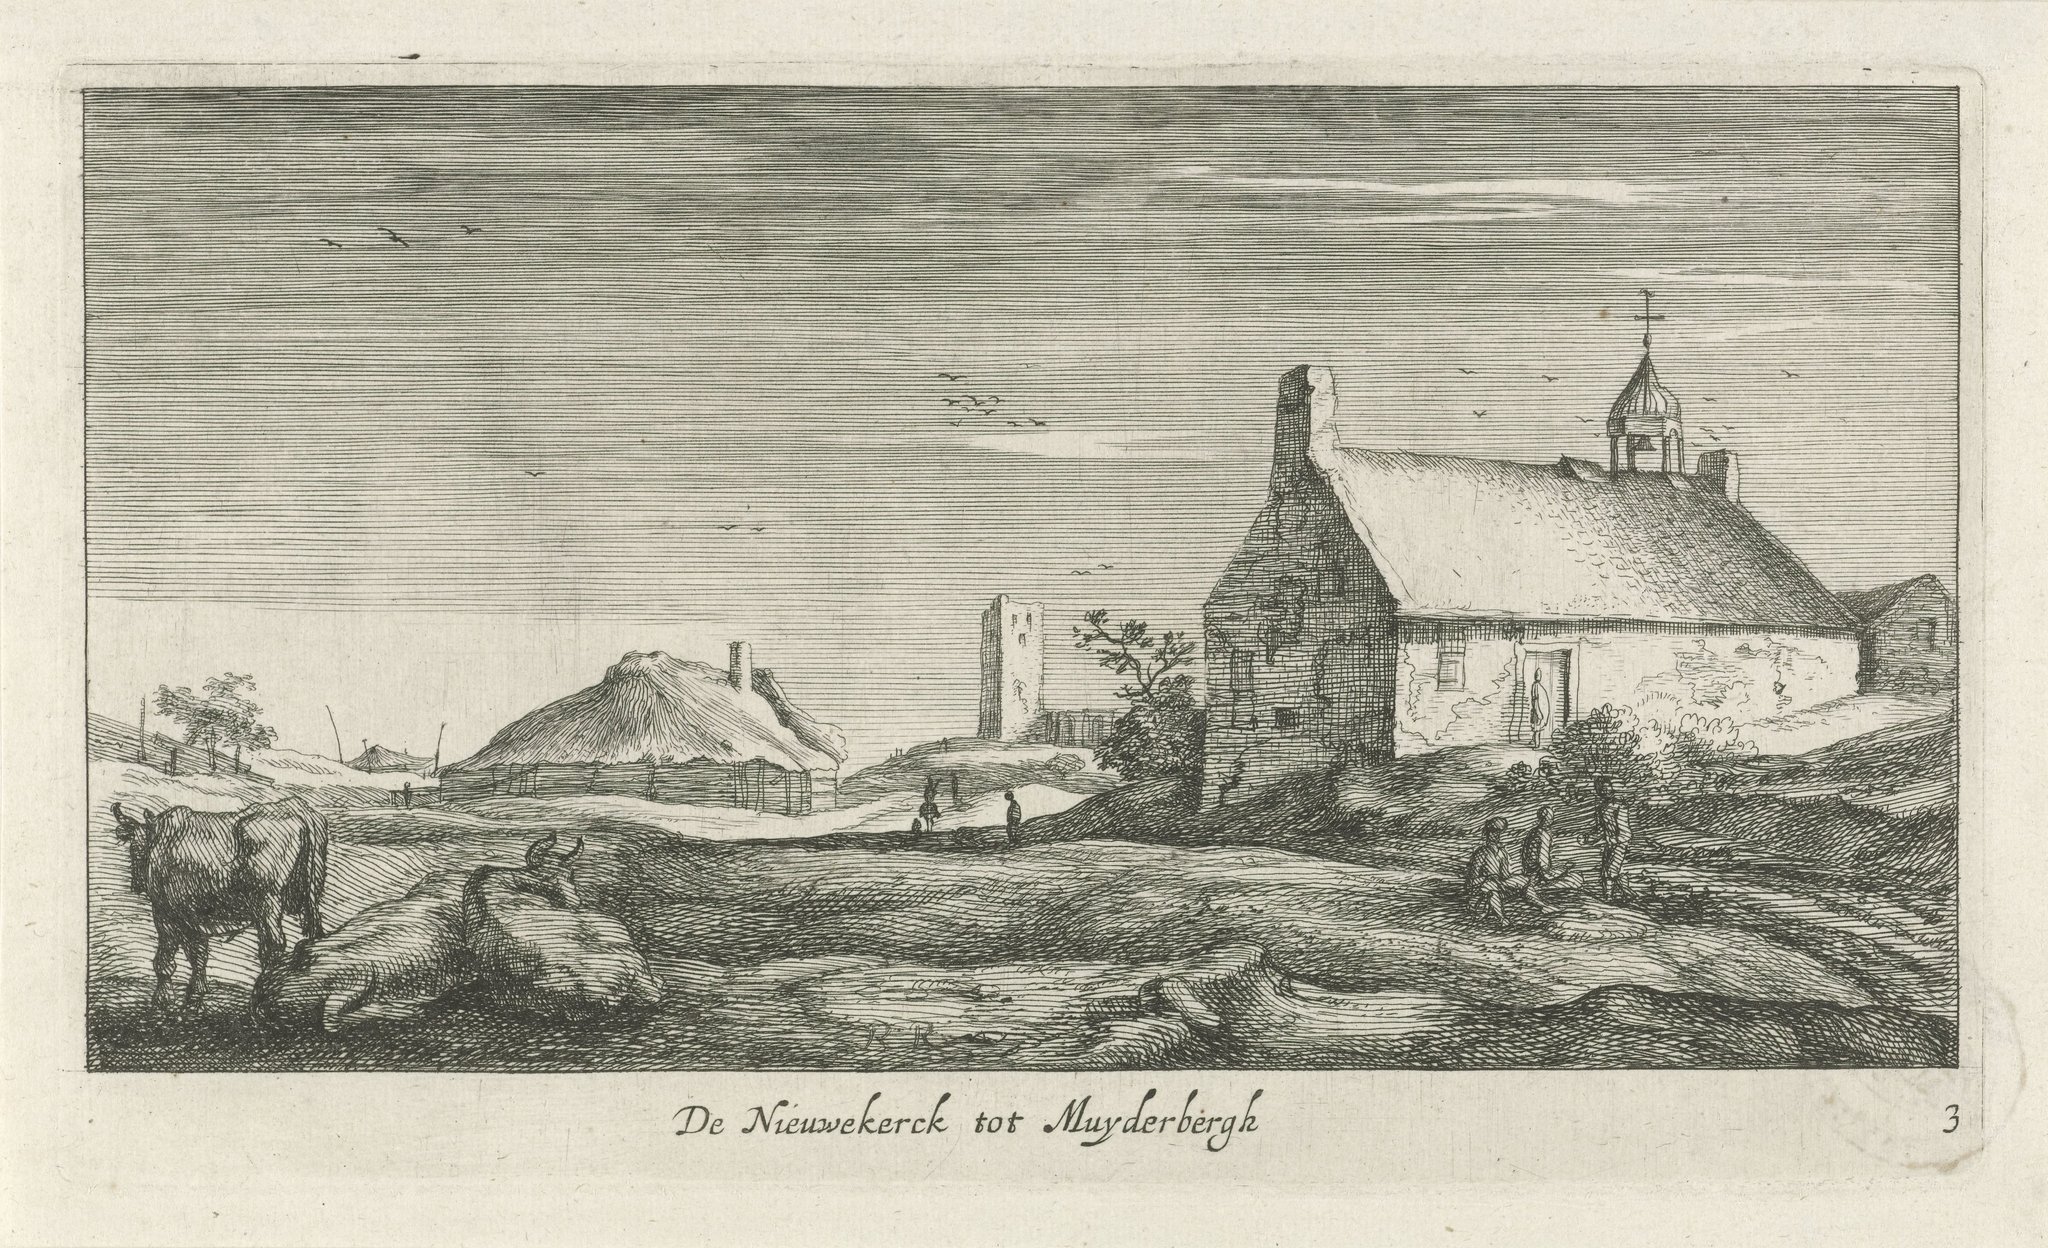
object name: print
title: Plaisante Lantschappen ofte vermakelijcke Gesichten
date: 1637-1652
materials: paper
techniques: engraving, etching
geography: amsterdam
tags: cow, church (exterior)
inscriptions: collector's mark: Lugt 240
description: Gezicht op het nieuwe kerkje te Muiderberg, ter vervanging van de verwoeste oude kerk (tegenwoordig de Kerk aan Zee genoemd). Op de achtergrond de toren van de oude kerk. De prent is deel van een serie landschappen met dorpen rondom Amsterdam. Rechtsonder genummerd: 3.